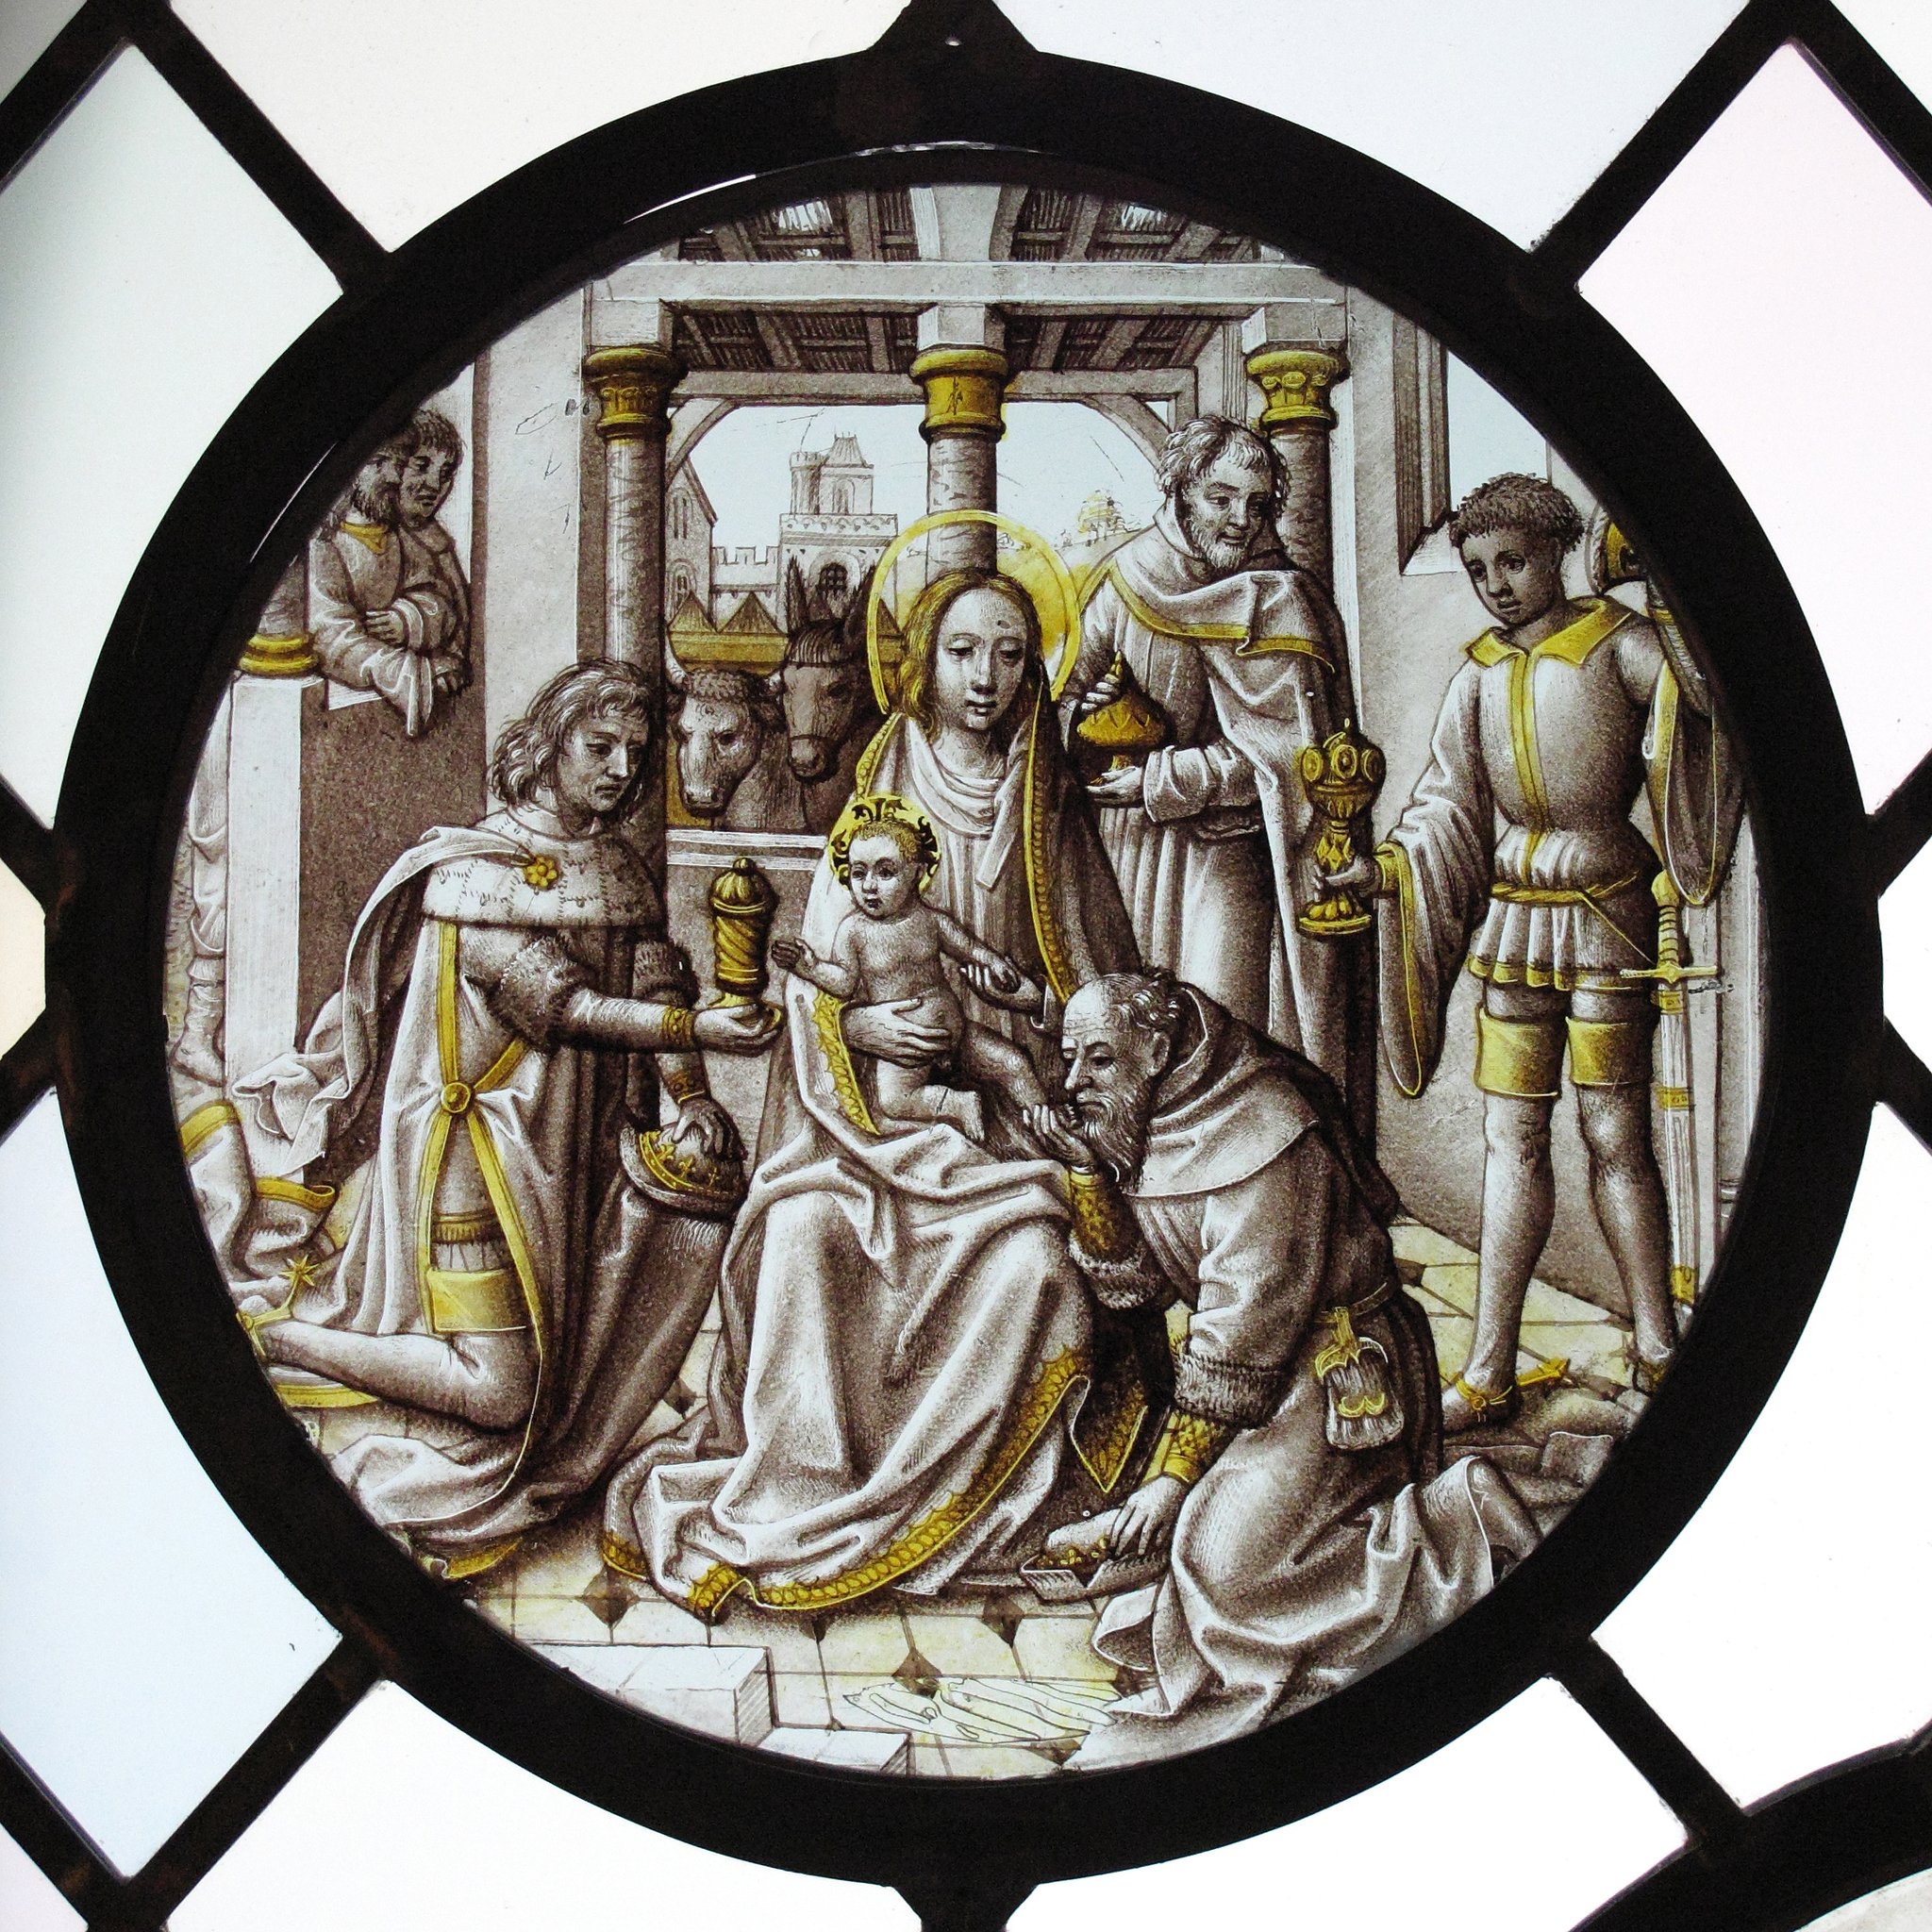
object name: roundel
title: Roundel with the Adoration of the Magi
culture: south netherlandish or lower german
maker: hans memling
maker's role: artist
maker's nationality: netherlandish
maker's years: 1465-1494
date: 1500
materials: glass, paint, pigment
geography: south netherlands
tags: donkeys,madonna and child,adoration of the magi,ox